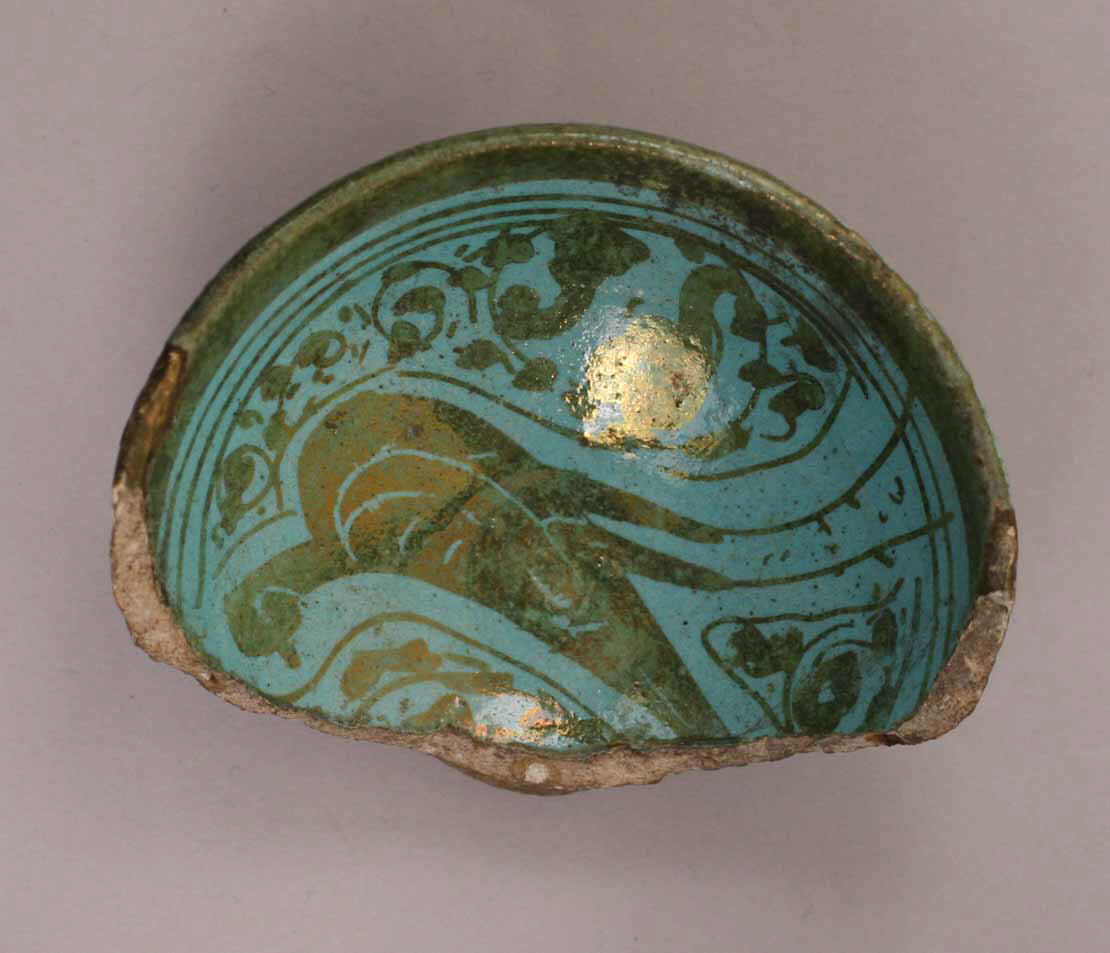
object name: fragment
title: Fragment of a Bowl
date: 1001-1200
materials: glaze, stonepaste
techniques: painting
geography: syria